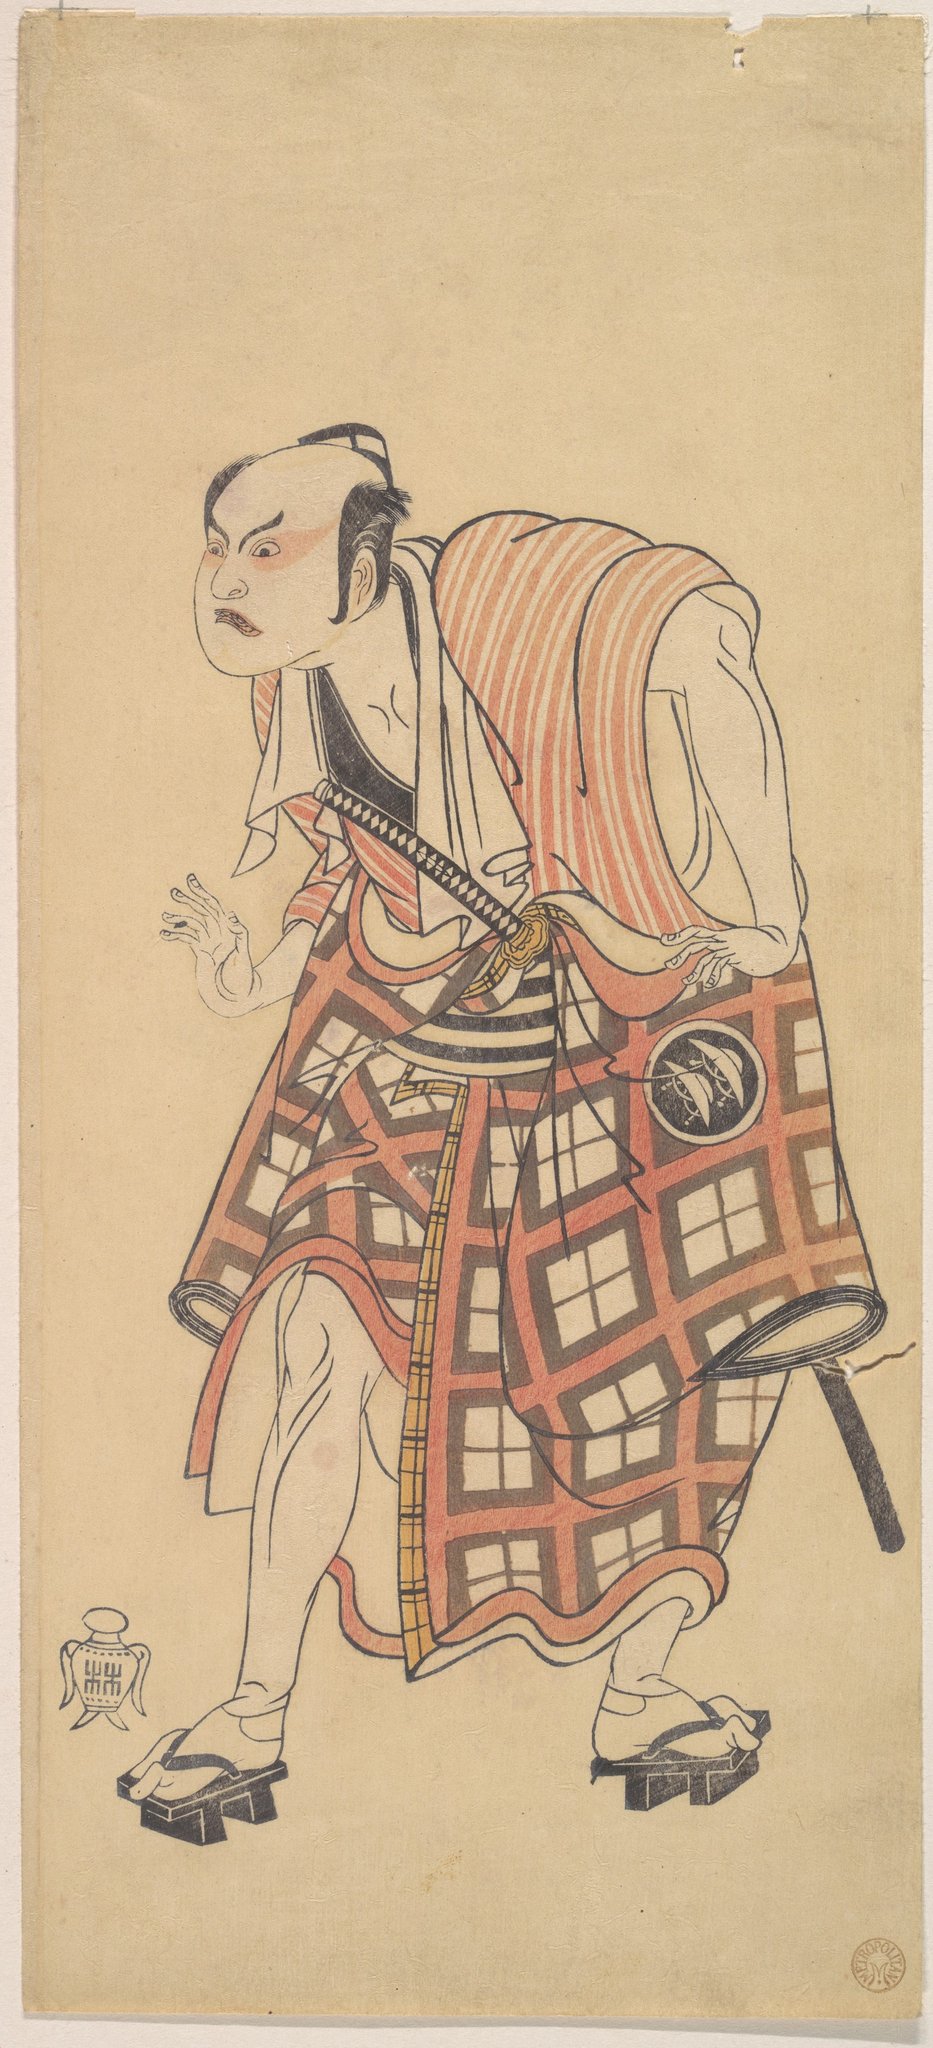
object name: woodblock print nishiki e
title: The Second Nakajima Mihoemon as a Man Standing with Head Bent Forward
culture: japanese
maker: katsukawa shunshō 勝川春章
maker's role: artist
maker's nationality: japanese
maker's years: 1726-1792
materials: ink, paper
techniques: nishiki e, woodblock print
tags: theatre,men,actors